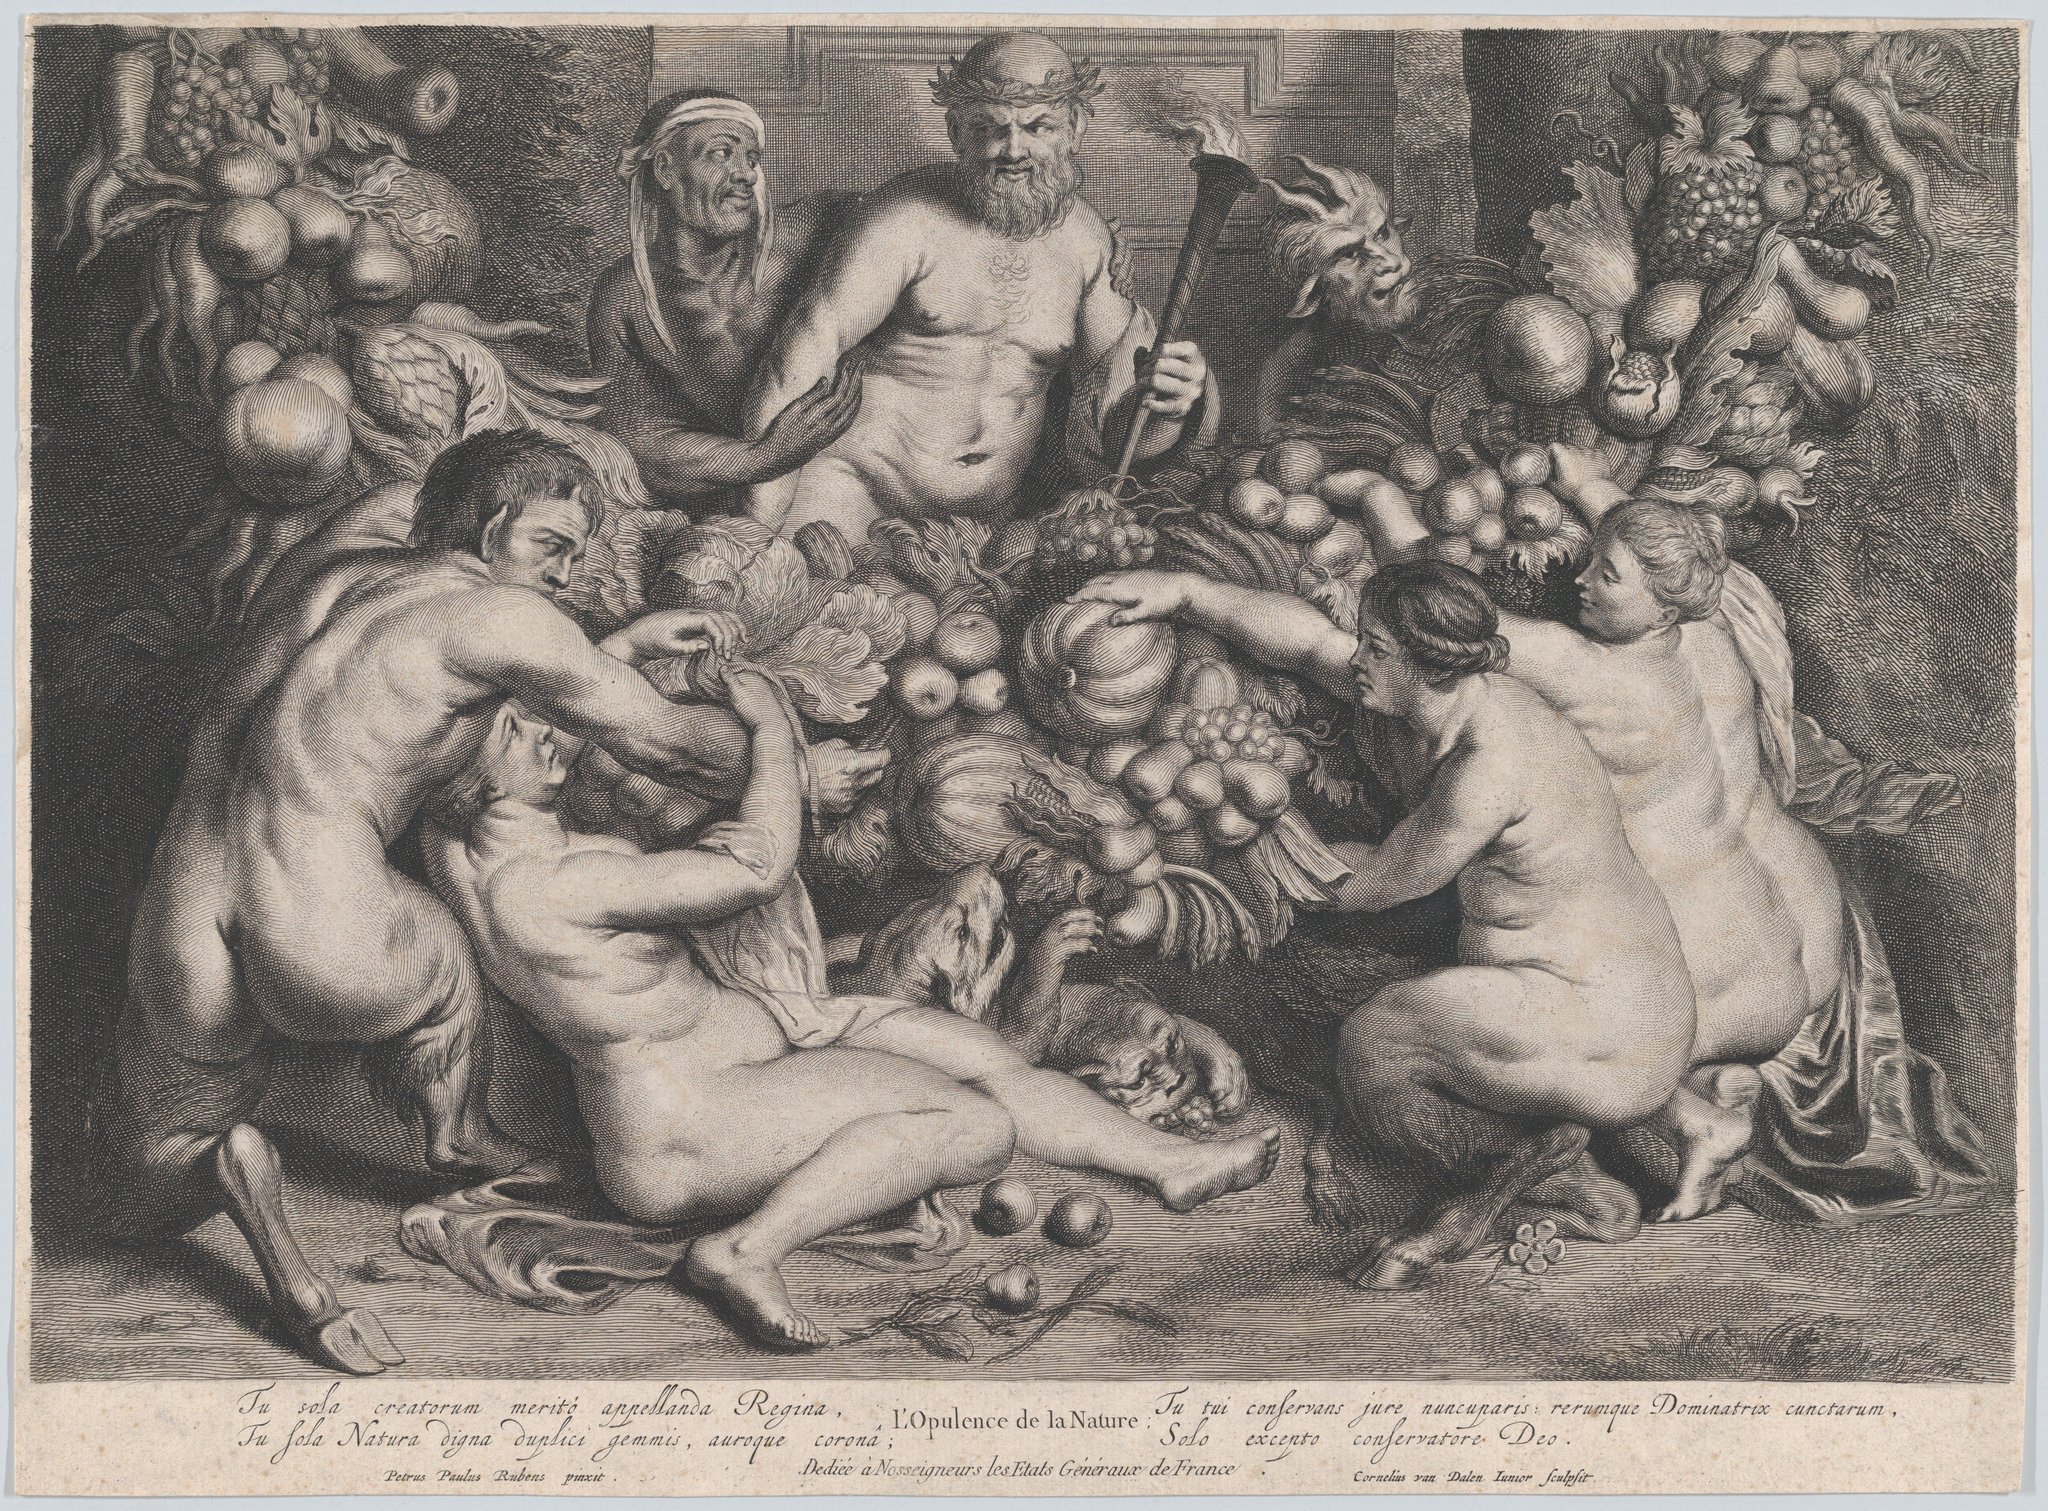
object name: print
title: The Opulence of Nature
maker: cornelis van dalen, the younger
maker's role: artist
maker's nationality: dutch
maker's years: 1638-1664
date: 1649-1664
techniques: engraving